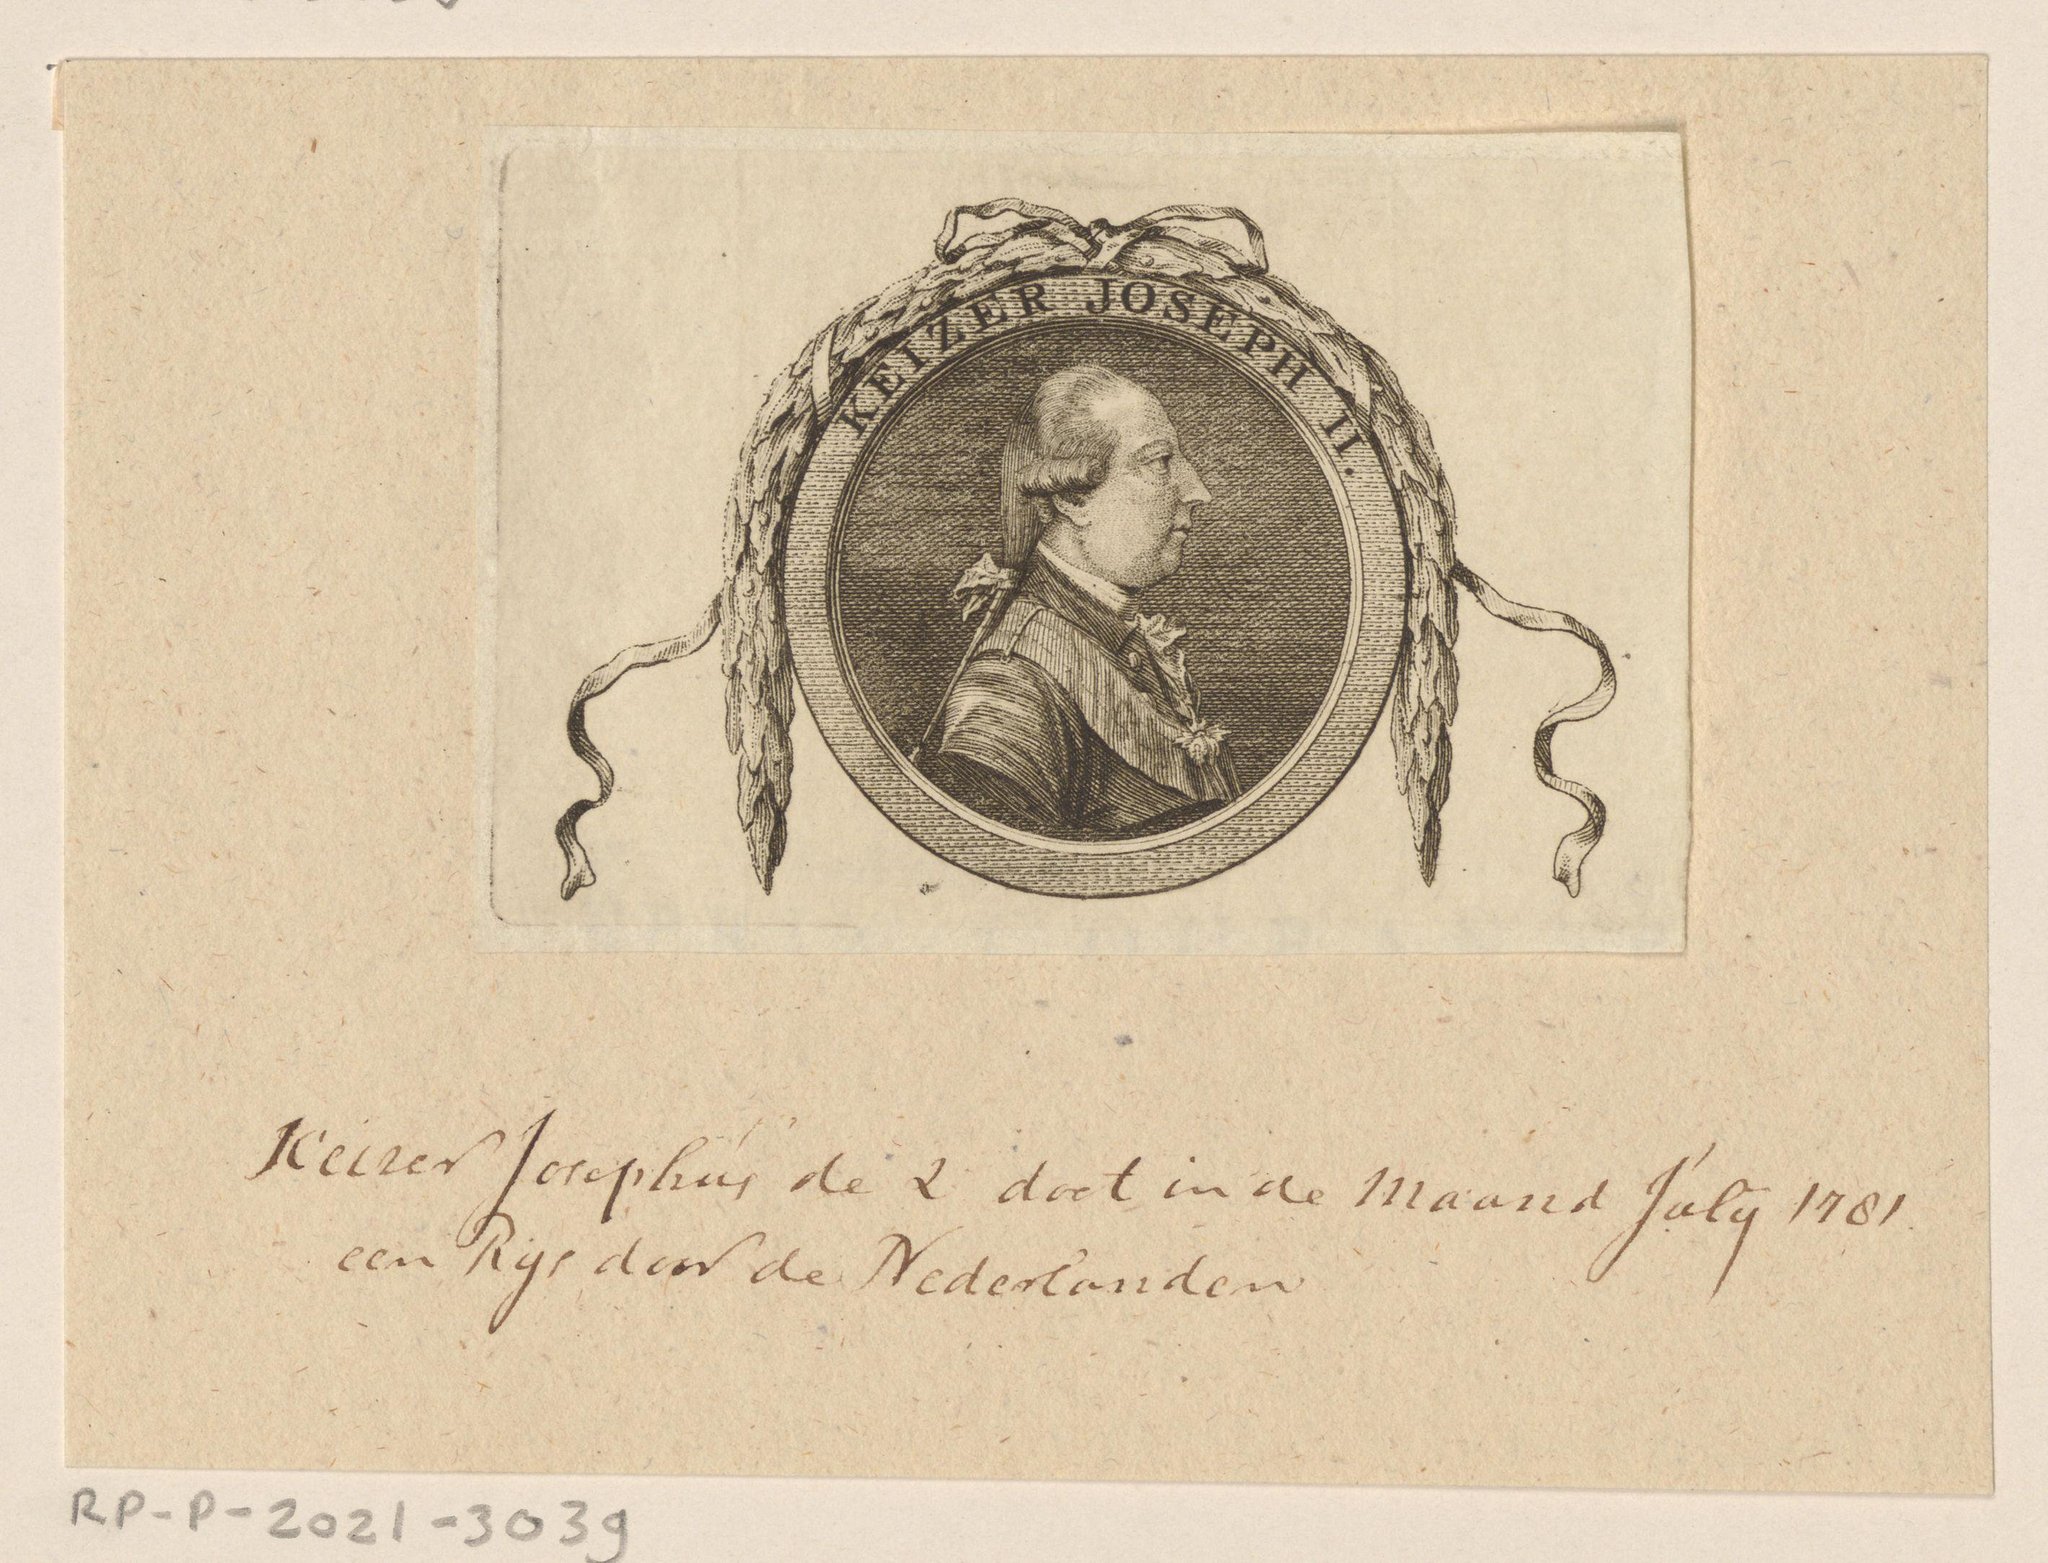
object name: print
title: Portret van Josef II, Duits keizer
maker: Anonymous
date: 1765-1799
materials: paper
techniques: engraving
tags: vienna, jozef ii (duits keizer), historical persons, emperor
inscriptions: inscription: ‘Keizer Josephus de 2 doet in de maan julij 1781/ een Rijs door de Nederlanden’